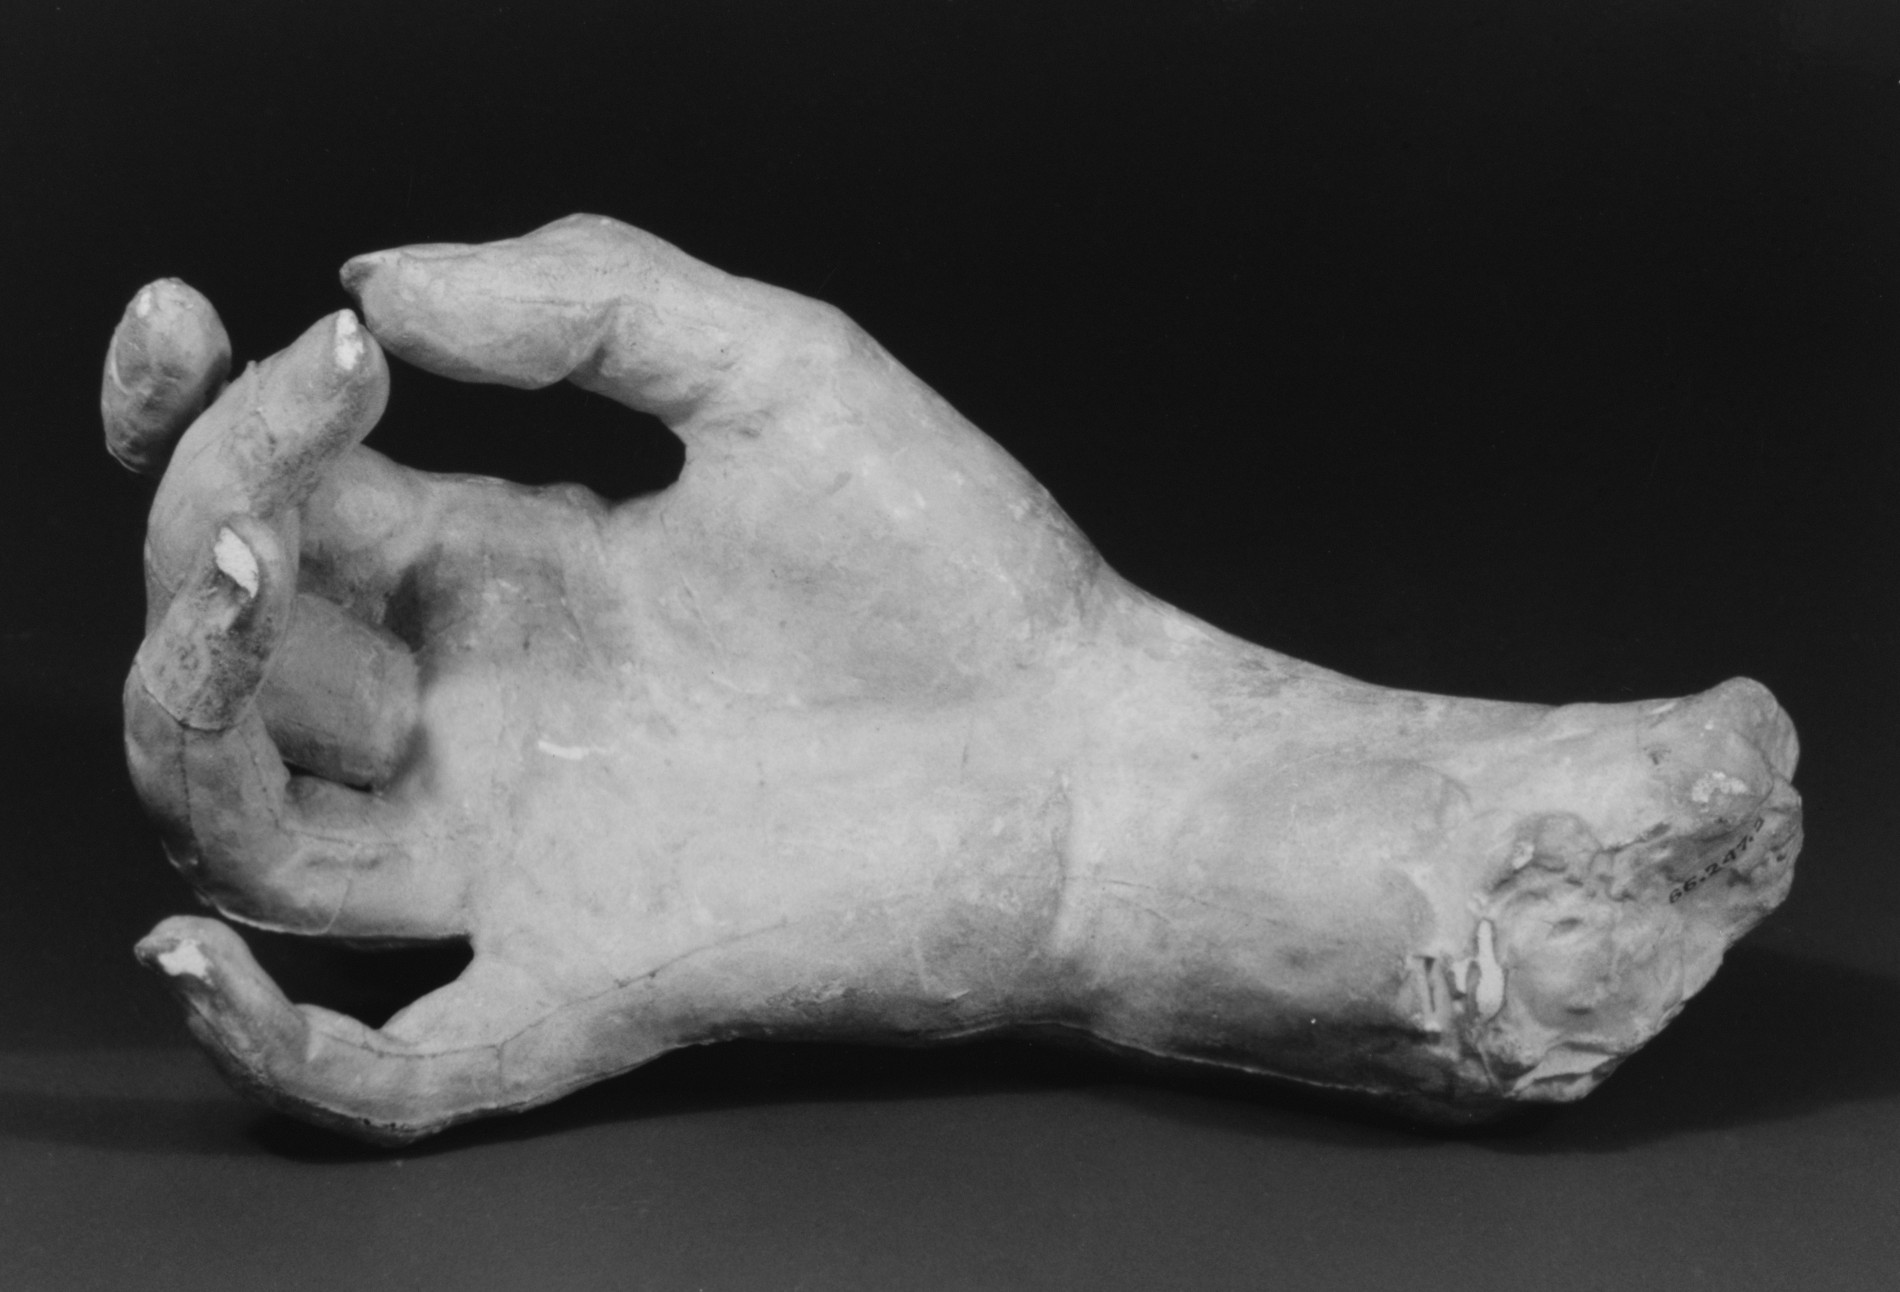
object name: cast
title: Girl's hand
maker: auguste rodin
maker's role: artist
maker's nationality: french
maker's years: 1840-1917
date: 1801-2000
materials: plaster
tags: hands